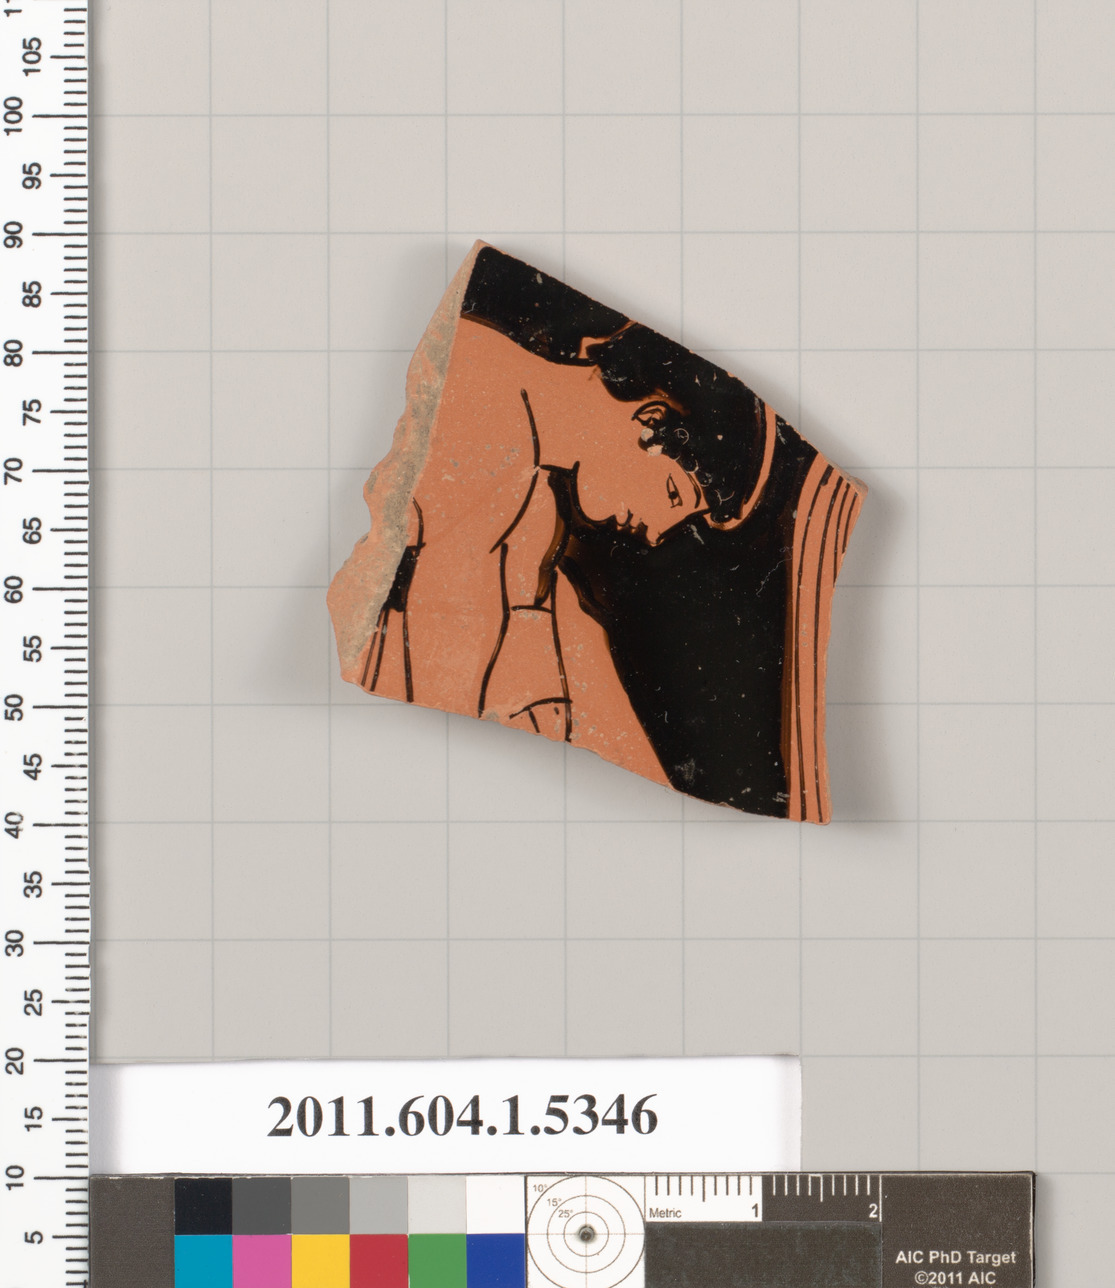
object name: kylix fragment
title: Terracotta fragment of a kylix (drinking cup)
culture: greek, attic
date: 500-490 BCE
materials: terracotta